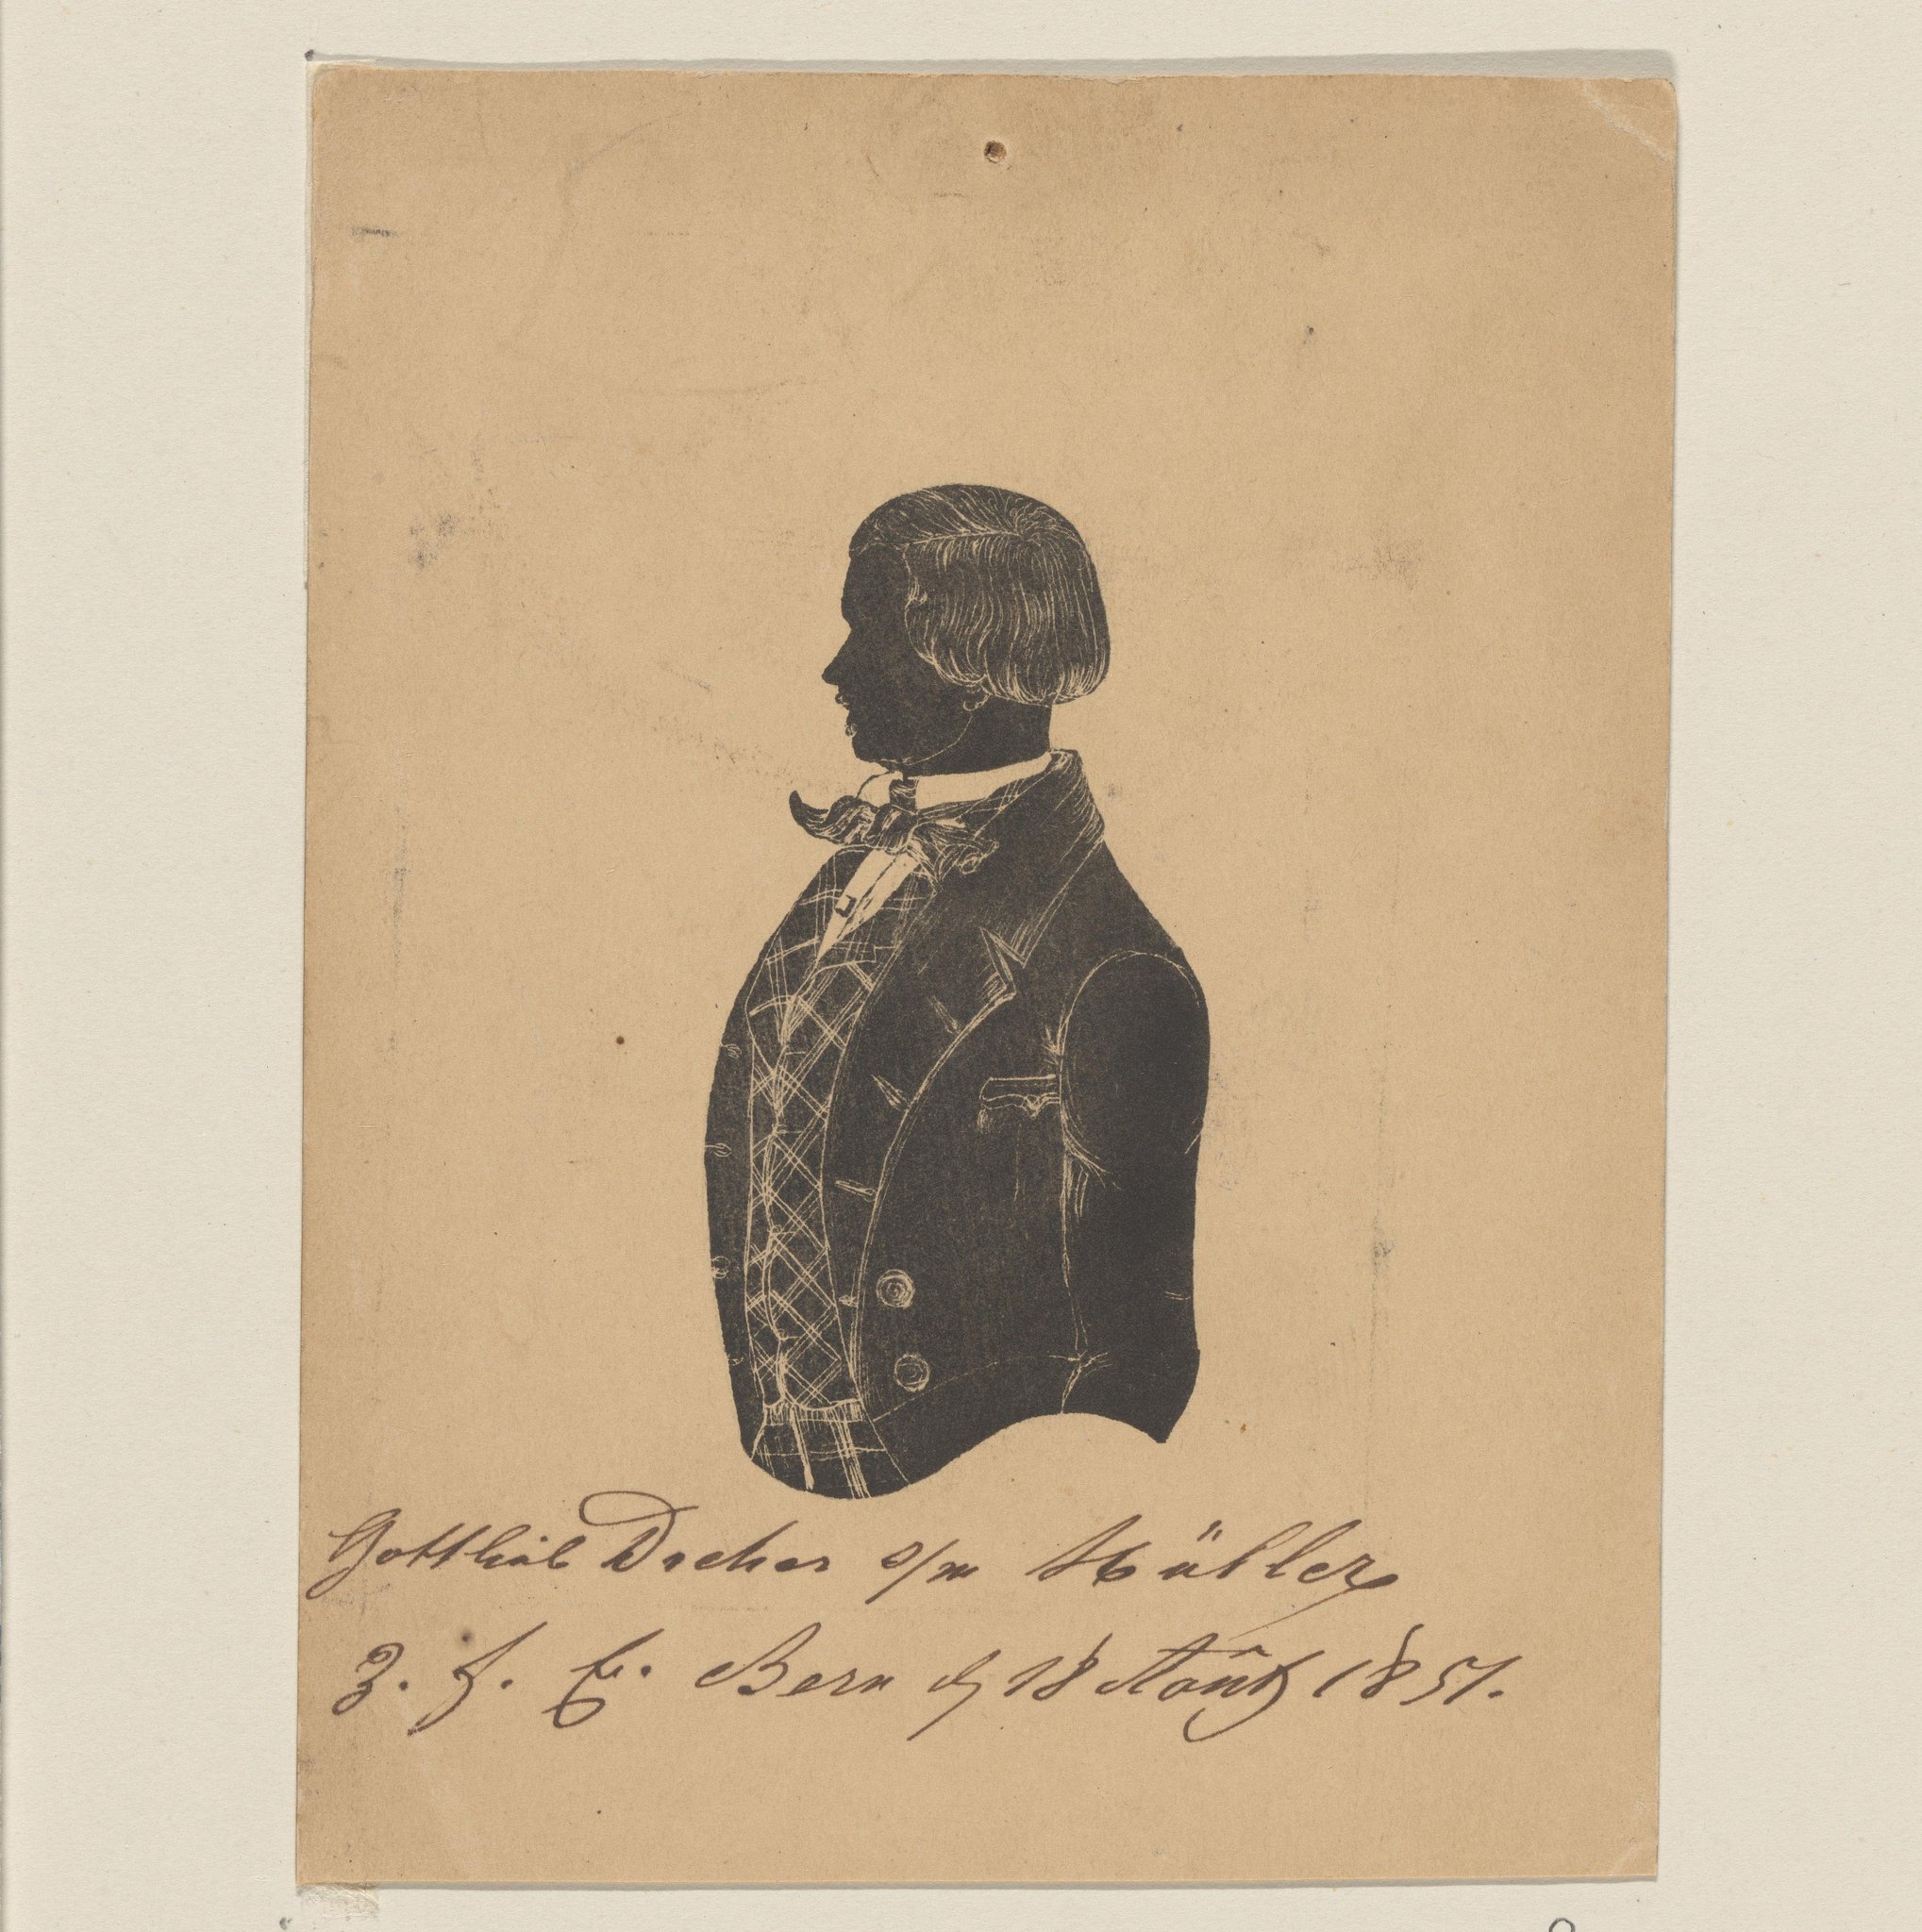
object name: print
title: Portret van Gottlieb Dreher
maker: Anonymous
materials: paper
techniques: etching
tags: historical persons, clothes for special purposes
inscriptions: collector's mark: Lugt 2228, inscription: ‘Gottlieb Dreher s/m Müller / z. f. E. Bern [...] 18 Aout 1857.’